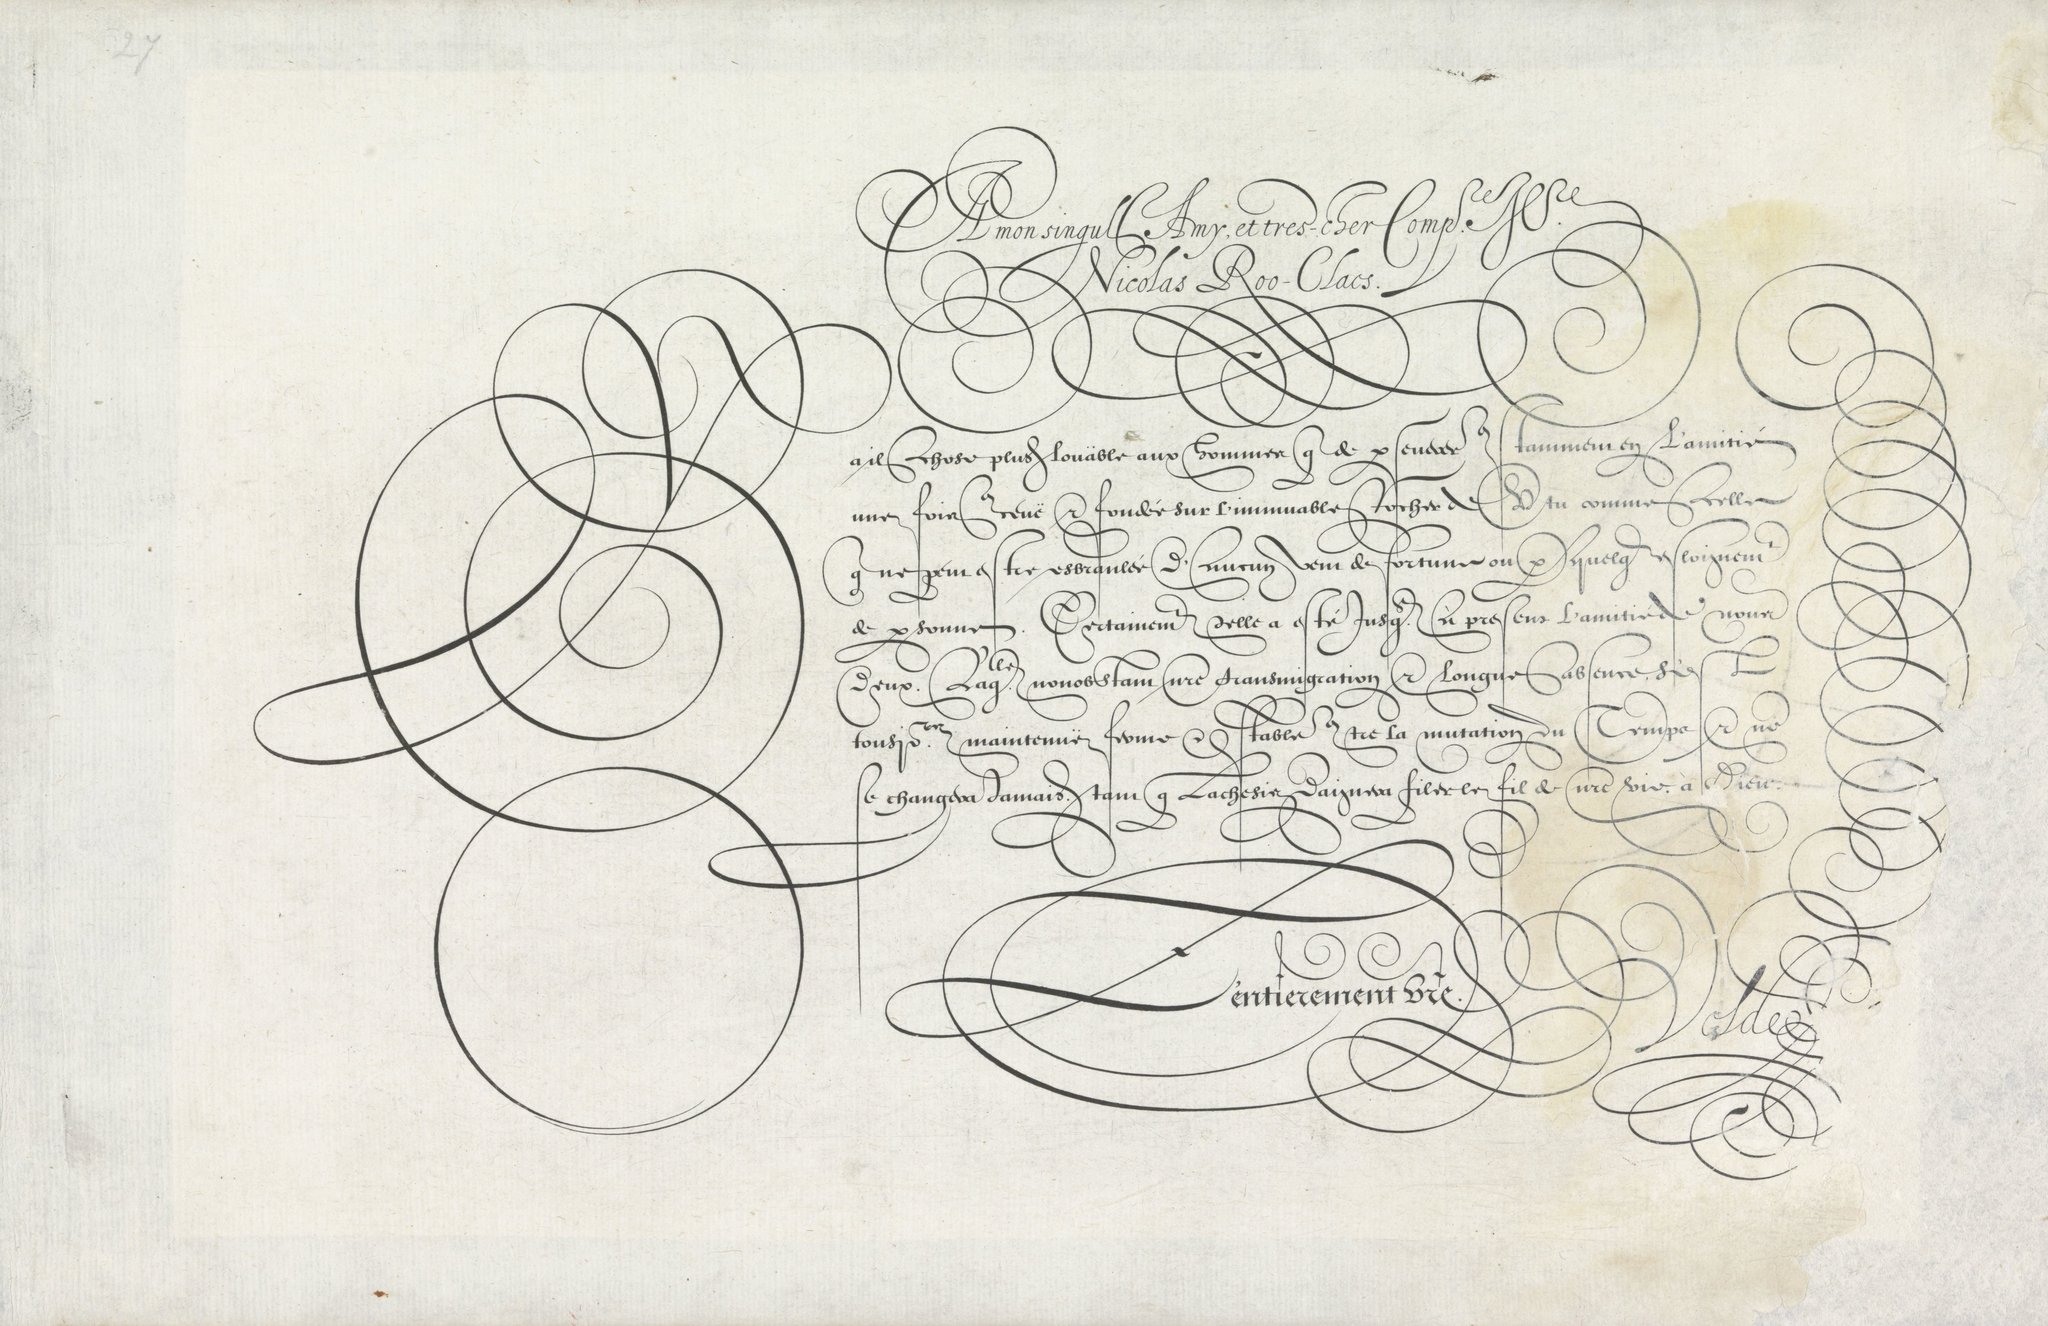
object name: album leaf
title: Schrijfvoorbeeld: A mon singul[ier] amy (...)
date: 1605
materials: paper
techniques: engraving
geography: rotterdam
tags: calligraphy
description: Schrijfvoorbeeld met de aanhef: A mon singul[ier] amy, et tres-cher comp[frere] Ill[ustre] Nicolas Roo-Claes. Daaronder in een andere letter een initiaal Y en zeven regels tekst in het Frans: Y a il chose ... De tekst is omlijst door krulwerk. De prent maakt deel uit van een album.